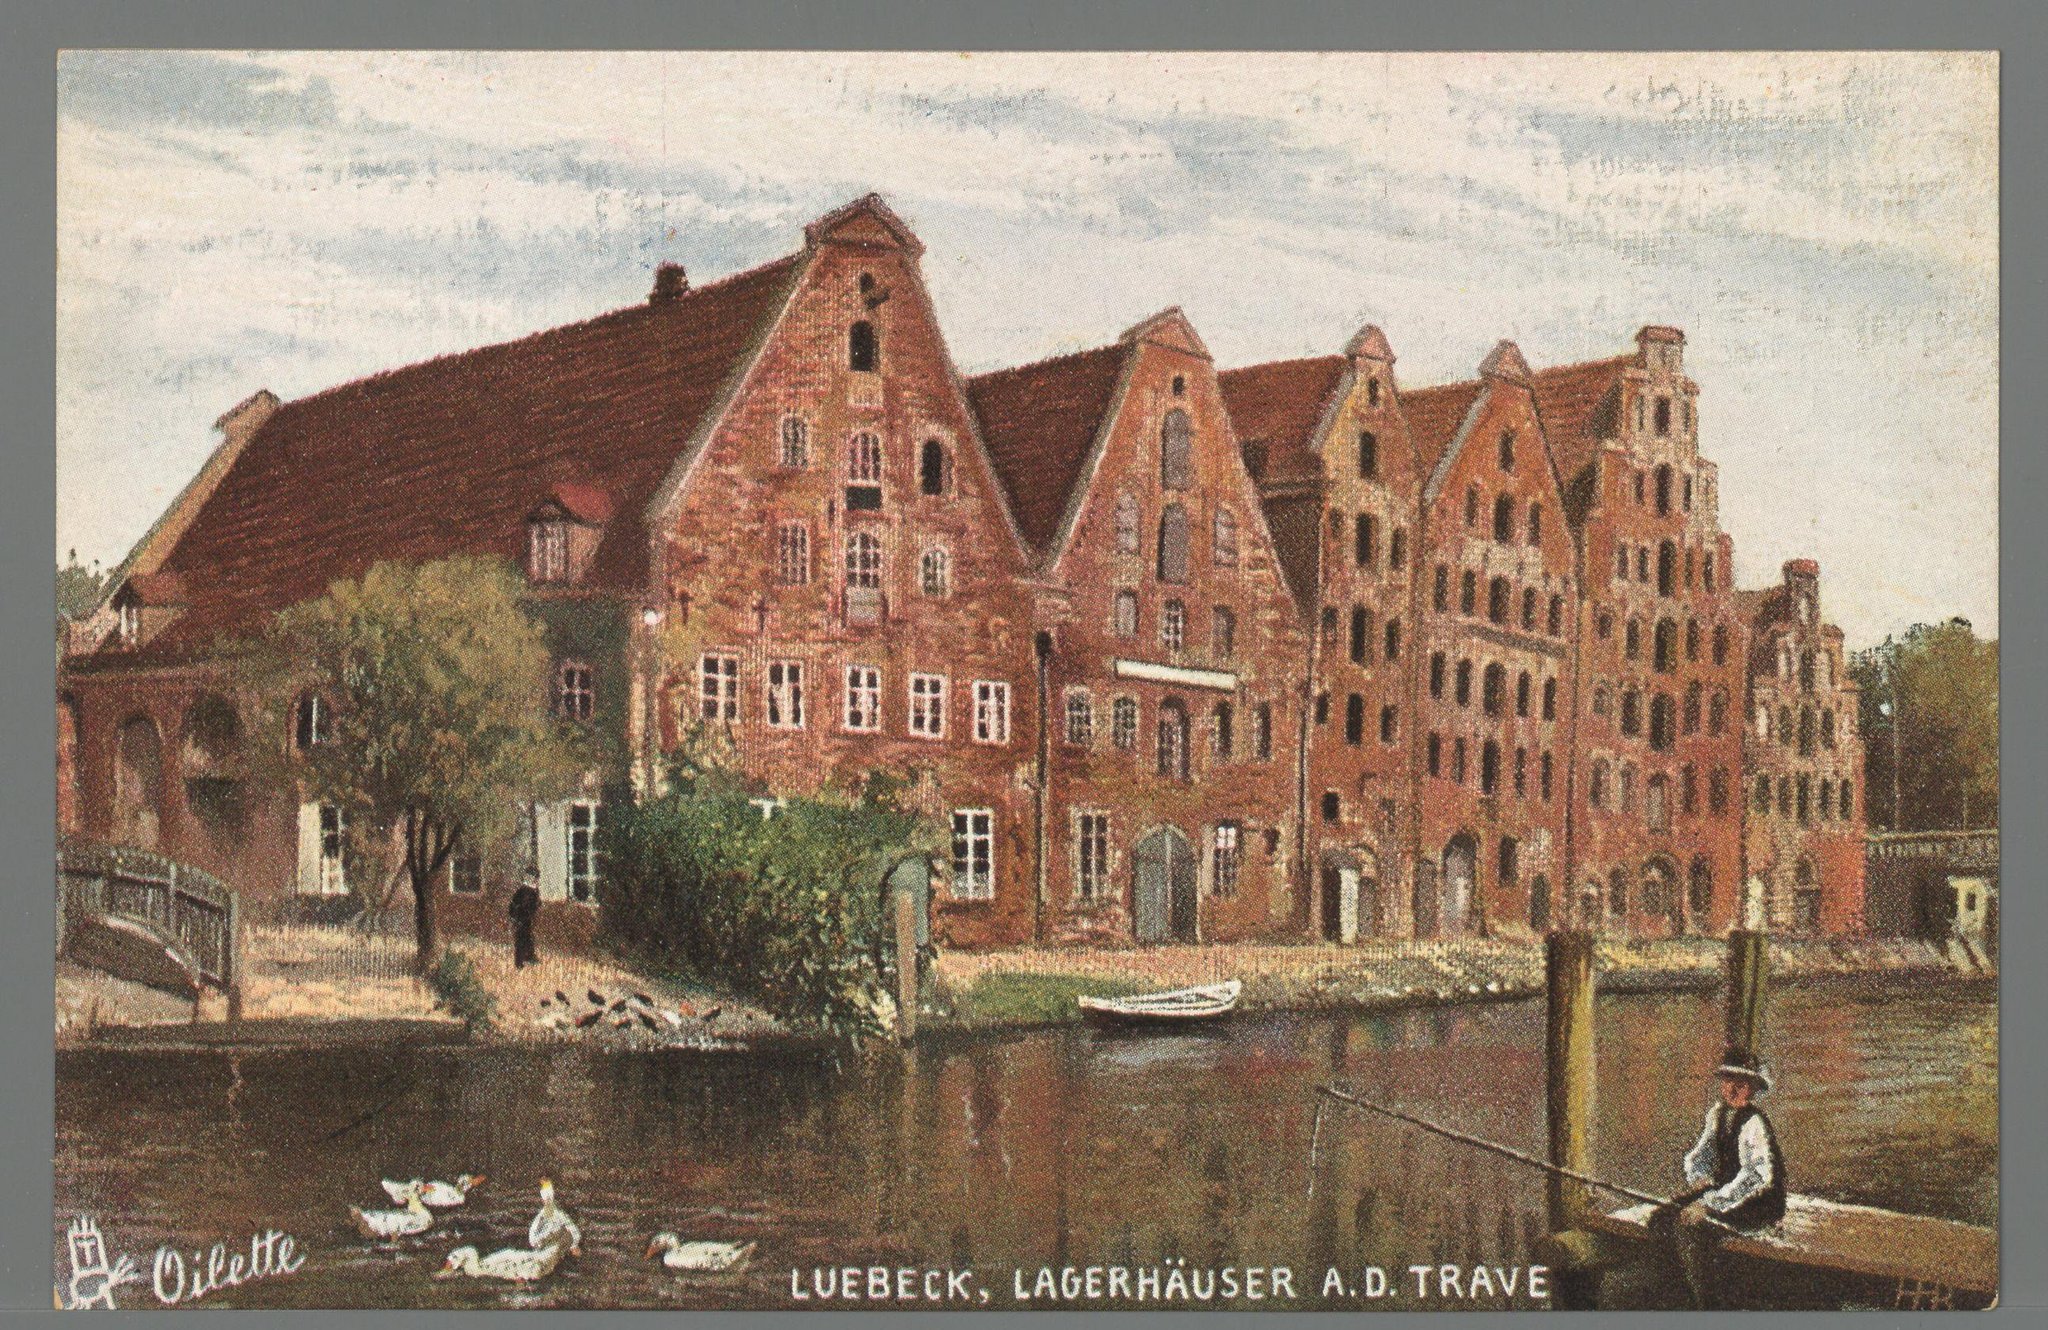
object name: reproduction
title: Luebeck, Lagerhäuser a.d. Trave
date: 1909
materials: cardboard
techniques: color autotype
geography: lübeck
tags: canals, waters (in city), street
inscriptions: inscription: ‘HR’